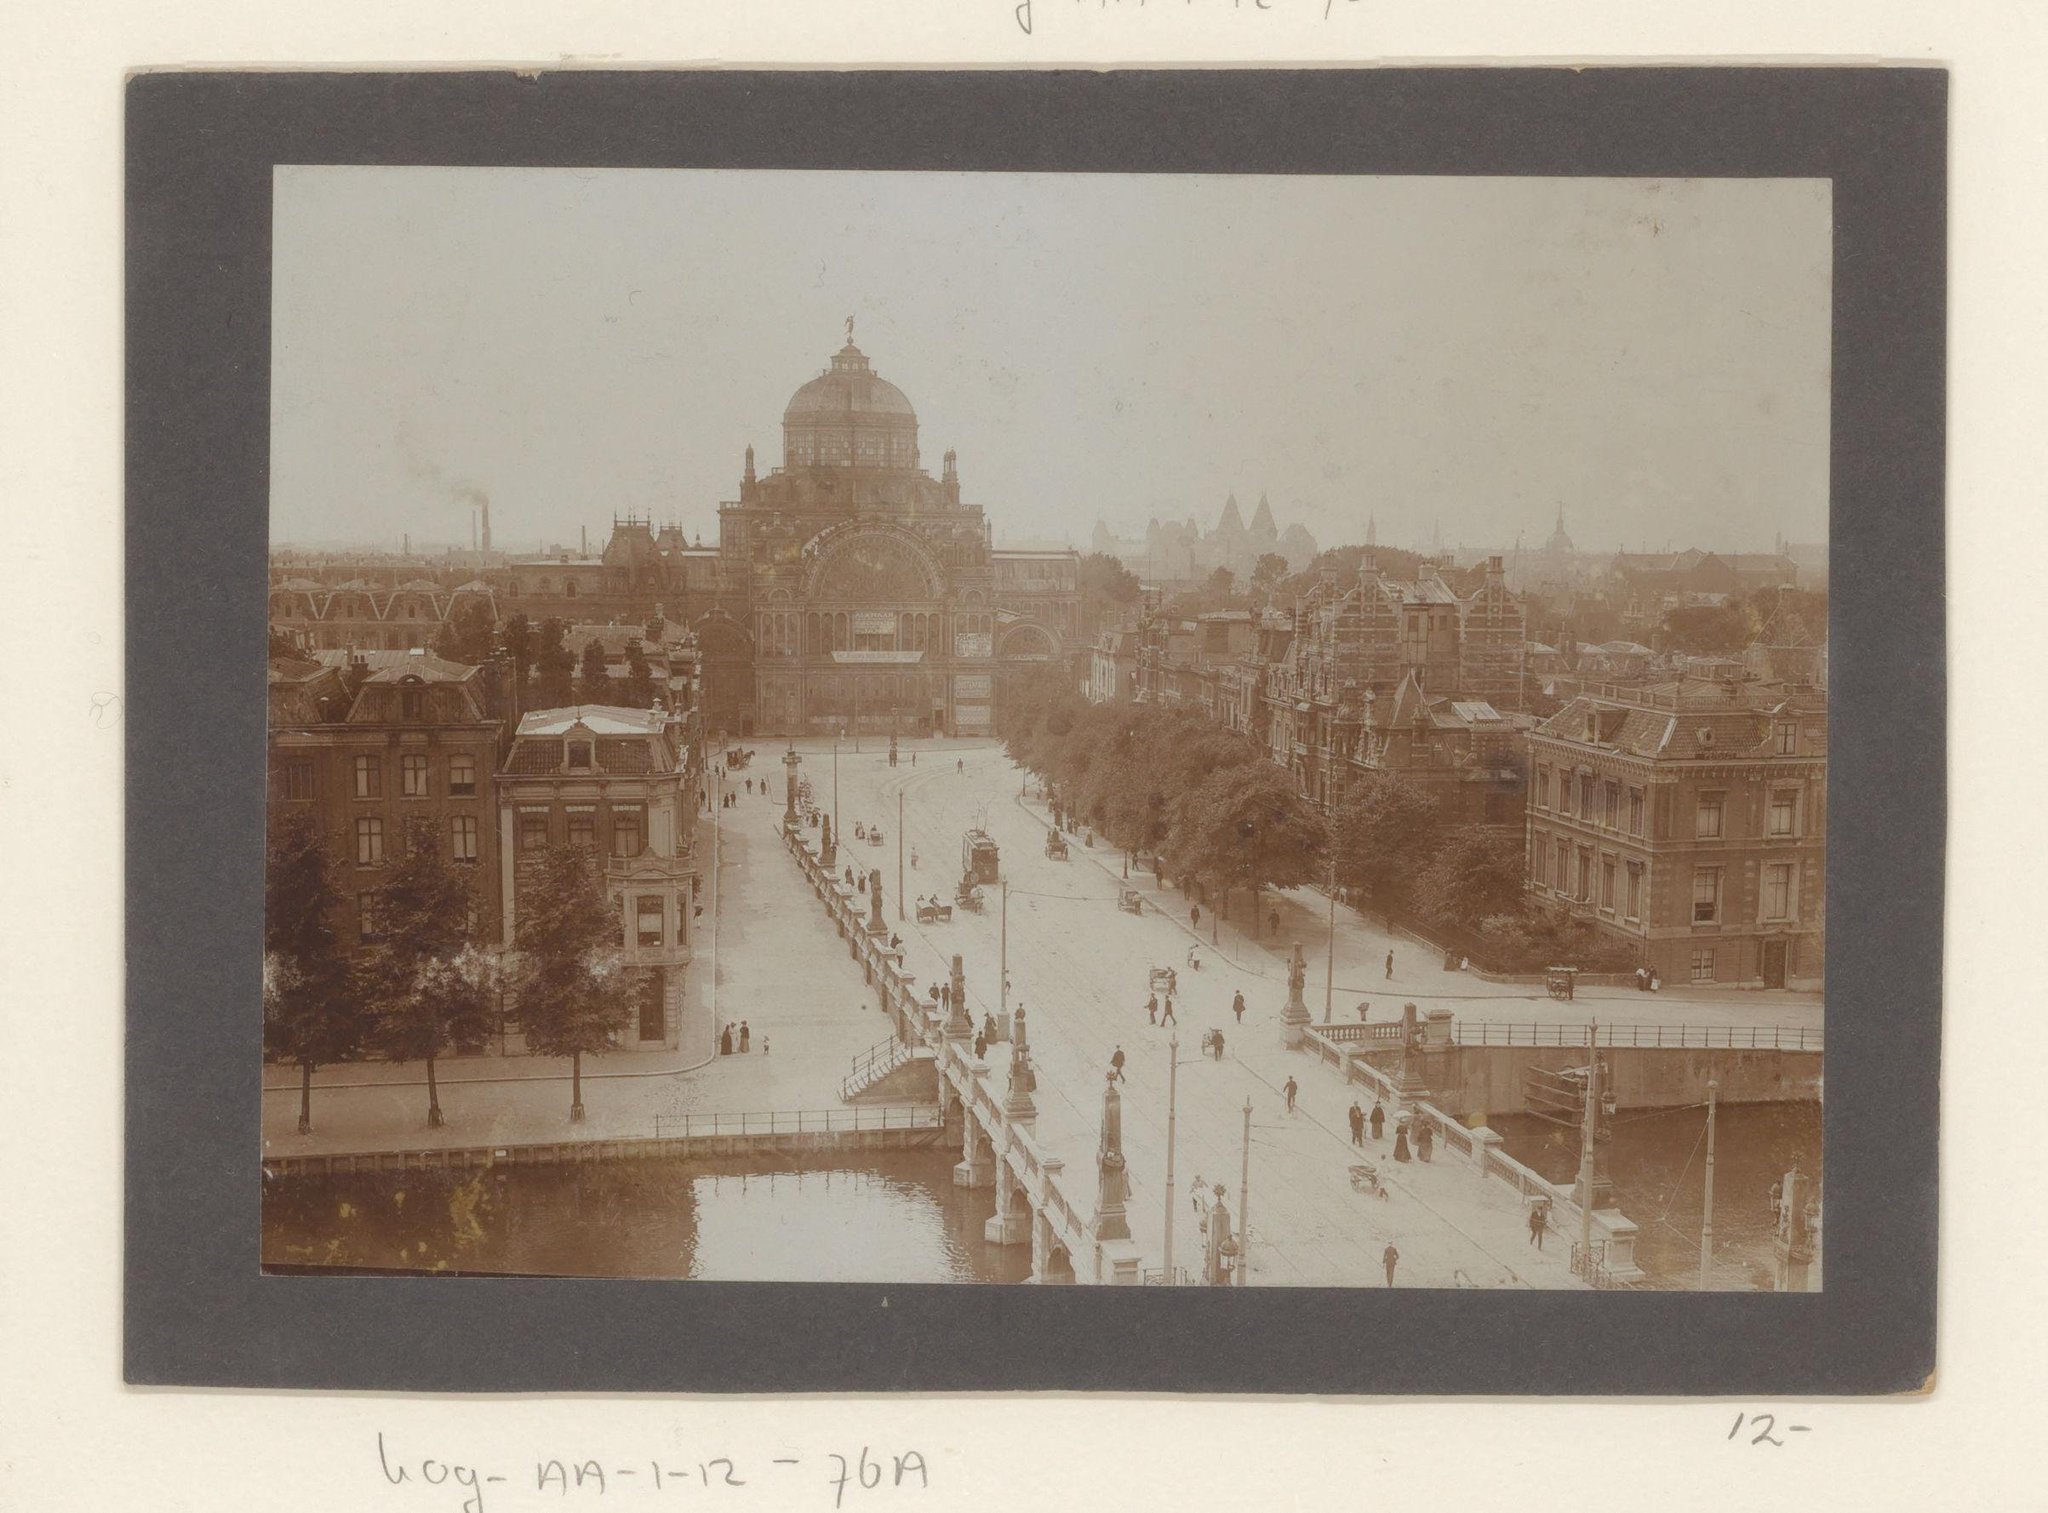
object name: cabinet photograph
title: Gezicht op het Paleis van Volksvlijt, gezien vanaf de Sarphatistraat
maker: Anonymous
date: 1865-1929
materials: paper, cardboard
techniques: collodion silver print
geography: amsterdam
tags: tramway, tram, city-view in general; 'veduta', river, permanent exhibition, museum, bridge in city across river, canal, etc., street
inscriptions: collector's mark: ‘12’ Lugt 1641b, inscription: ‘Sarphatistraat’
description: Onderwerpsrubriek binnen de Atlas Amsterdam: Sarphatistraat, Schans.